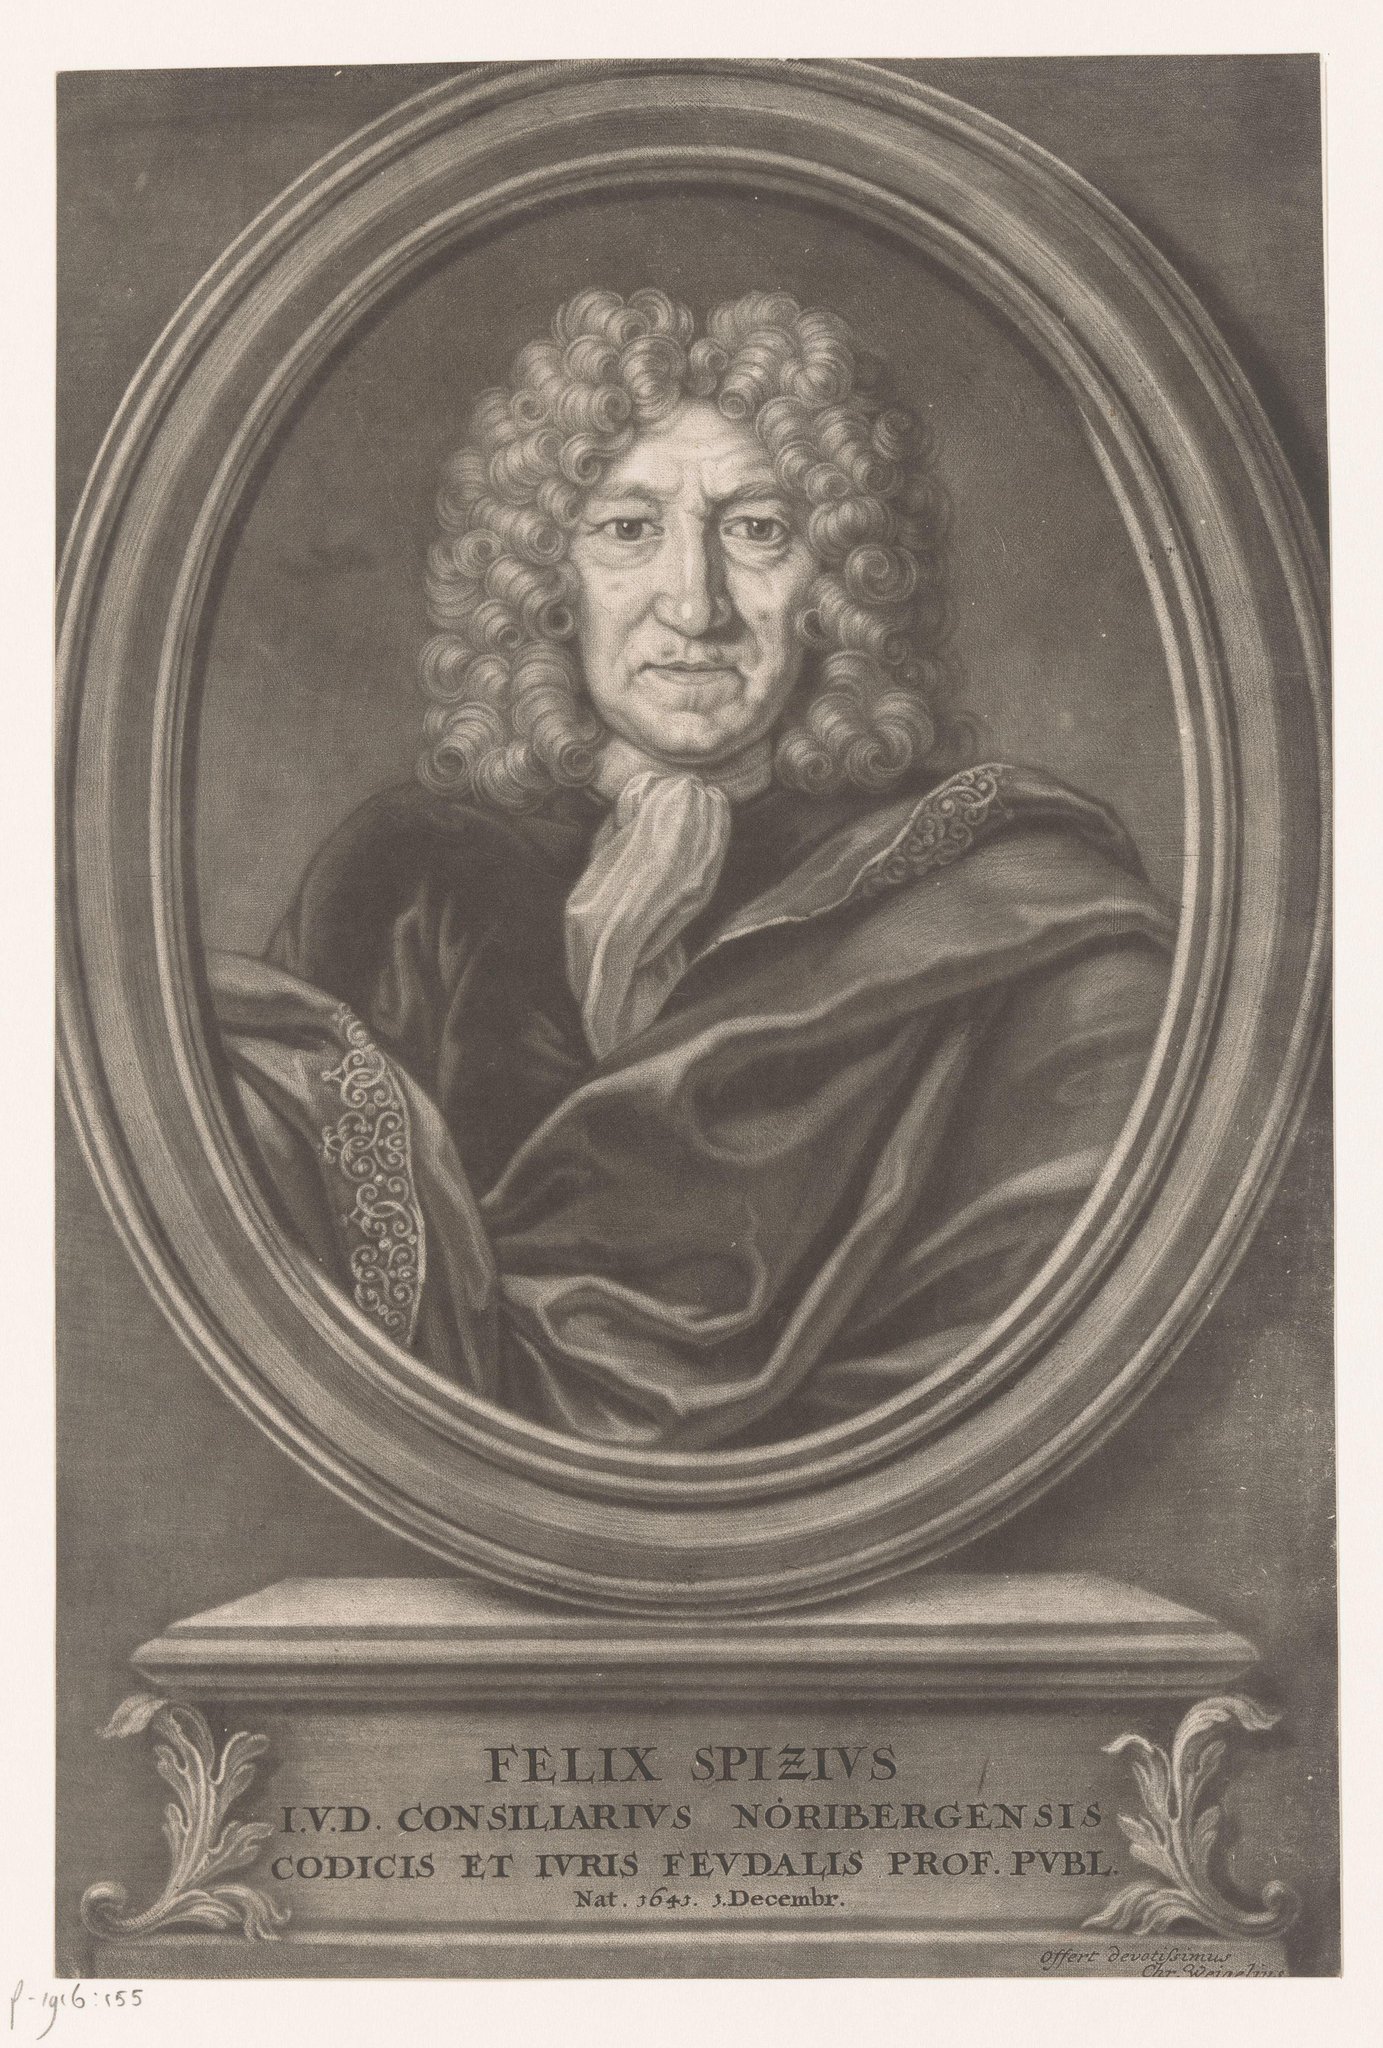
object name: print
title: Portret van Felix Spitz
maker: christoph weigel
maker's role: goldsmith, print maker, publisher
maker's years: 1654-1725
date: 1664-1725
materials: paper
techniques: mezzotint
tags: historical persons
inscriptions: collector's mark: Lugt 2228